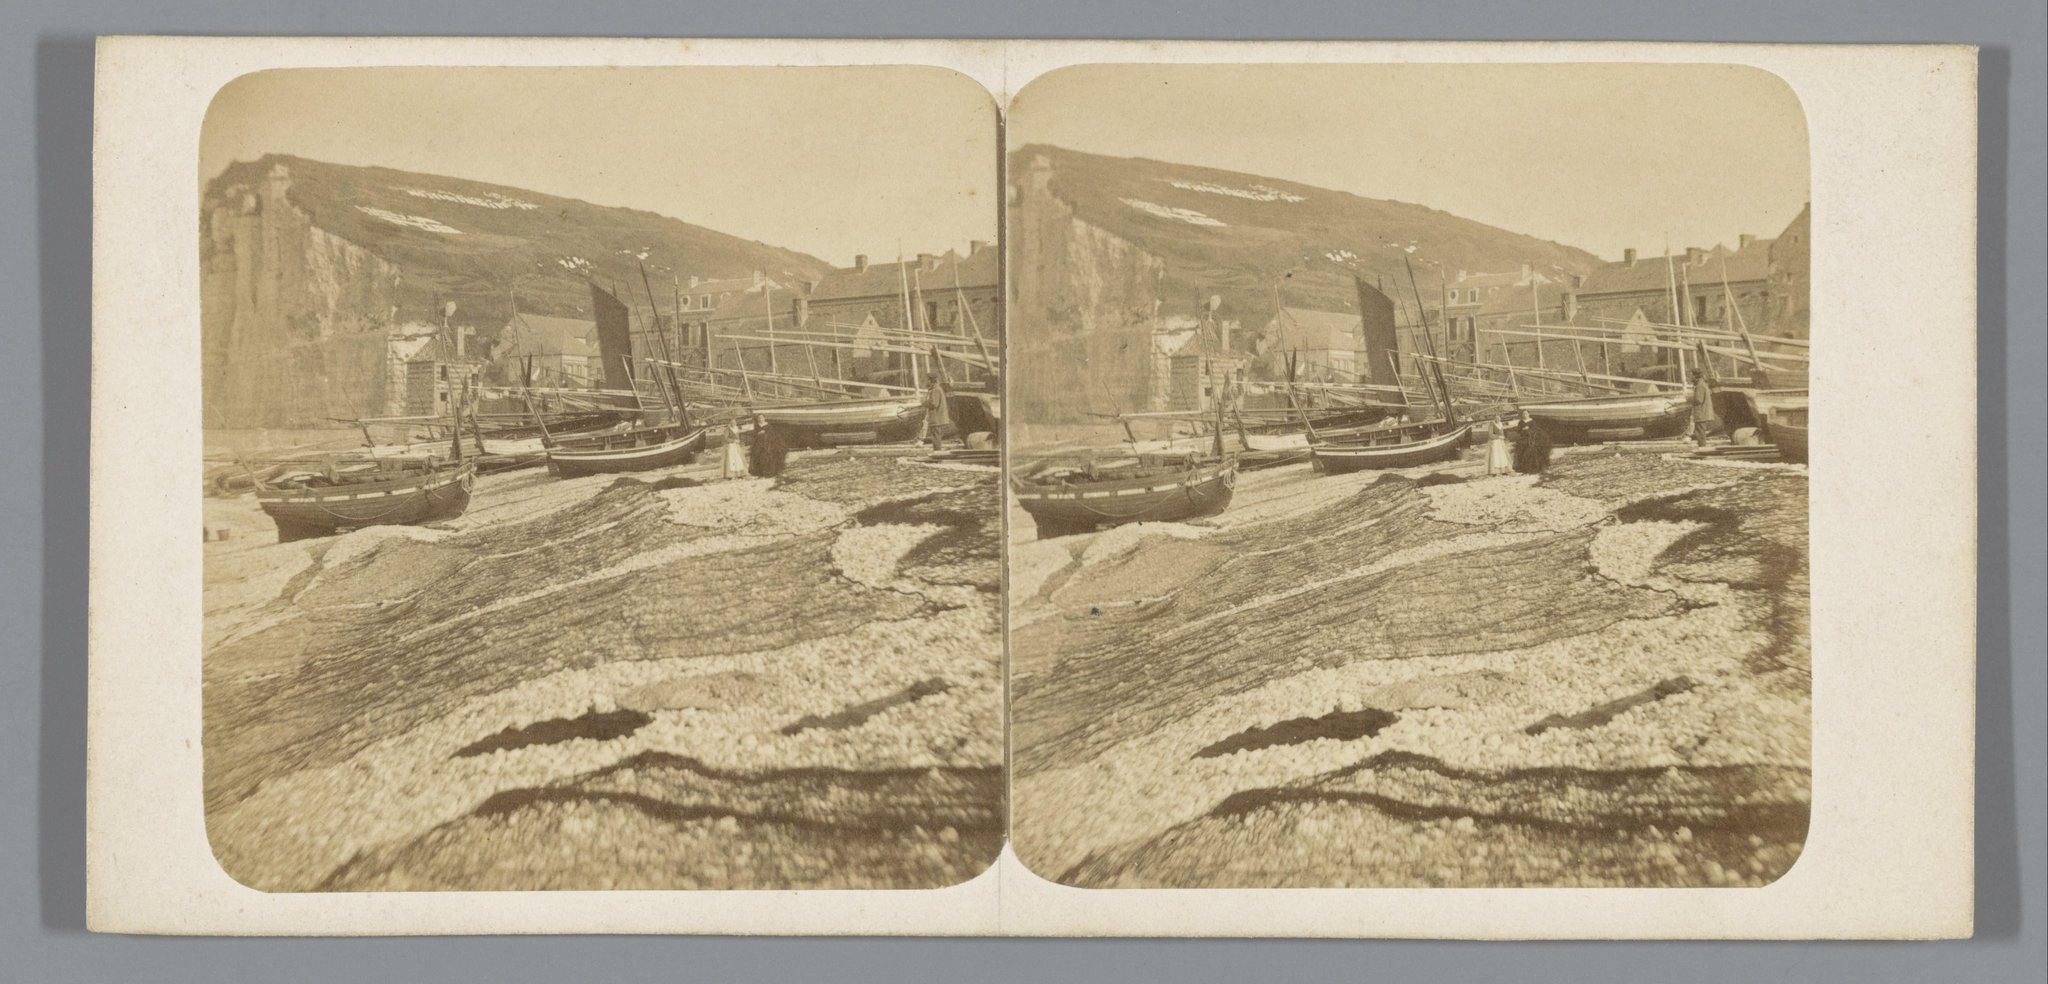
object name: stereograph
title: Schepen op het strand van Yport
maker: Anonymous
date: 1860-1880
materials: cardboard, photographic support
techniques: albumen print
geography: yport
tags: ships, boats on land, beached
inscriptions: number: ‘No 30’